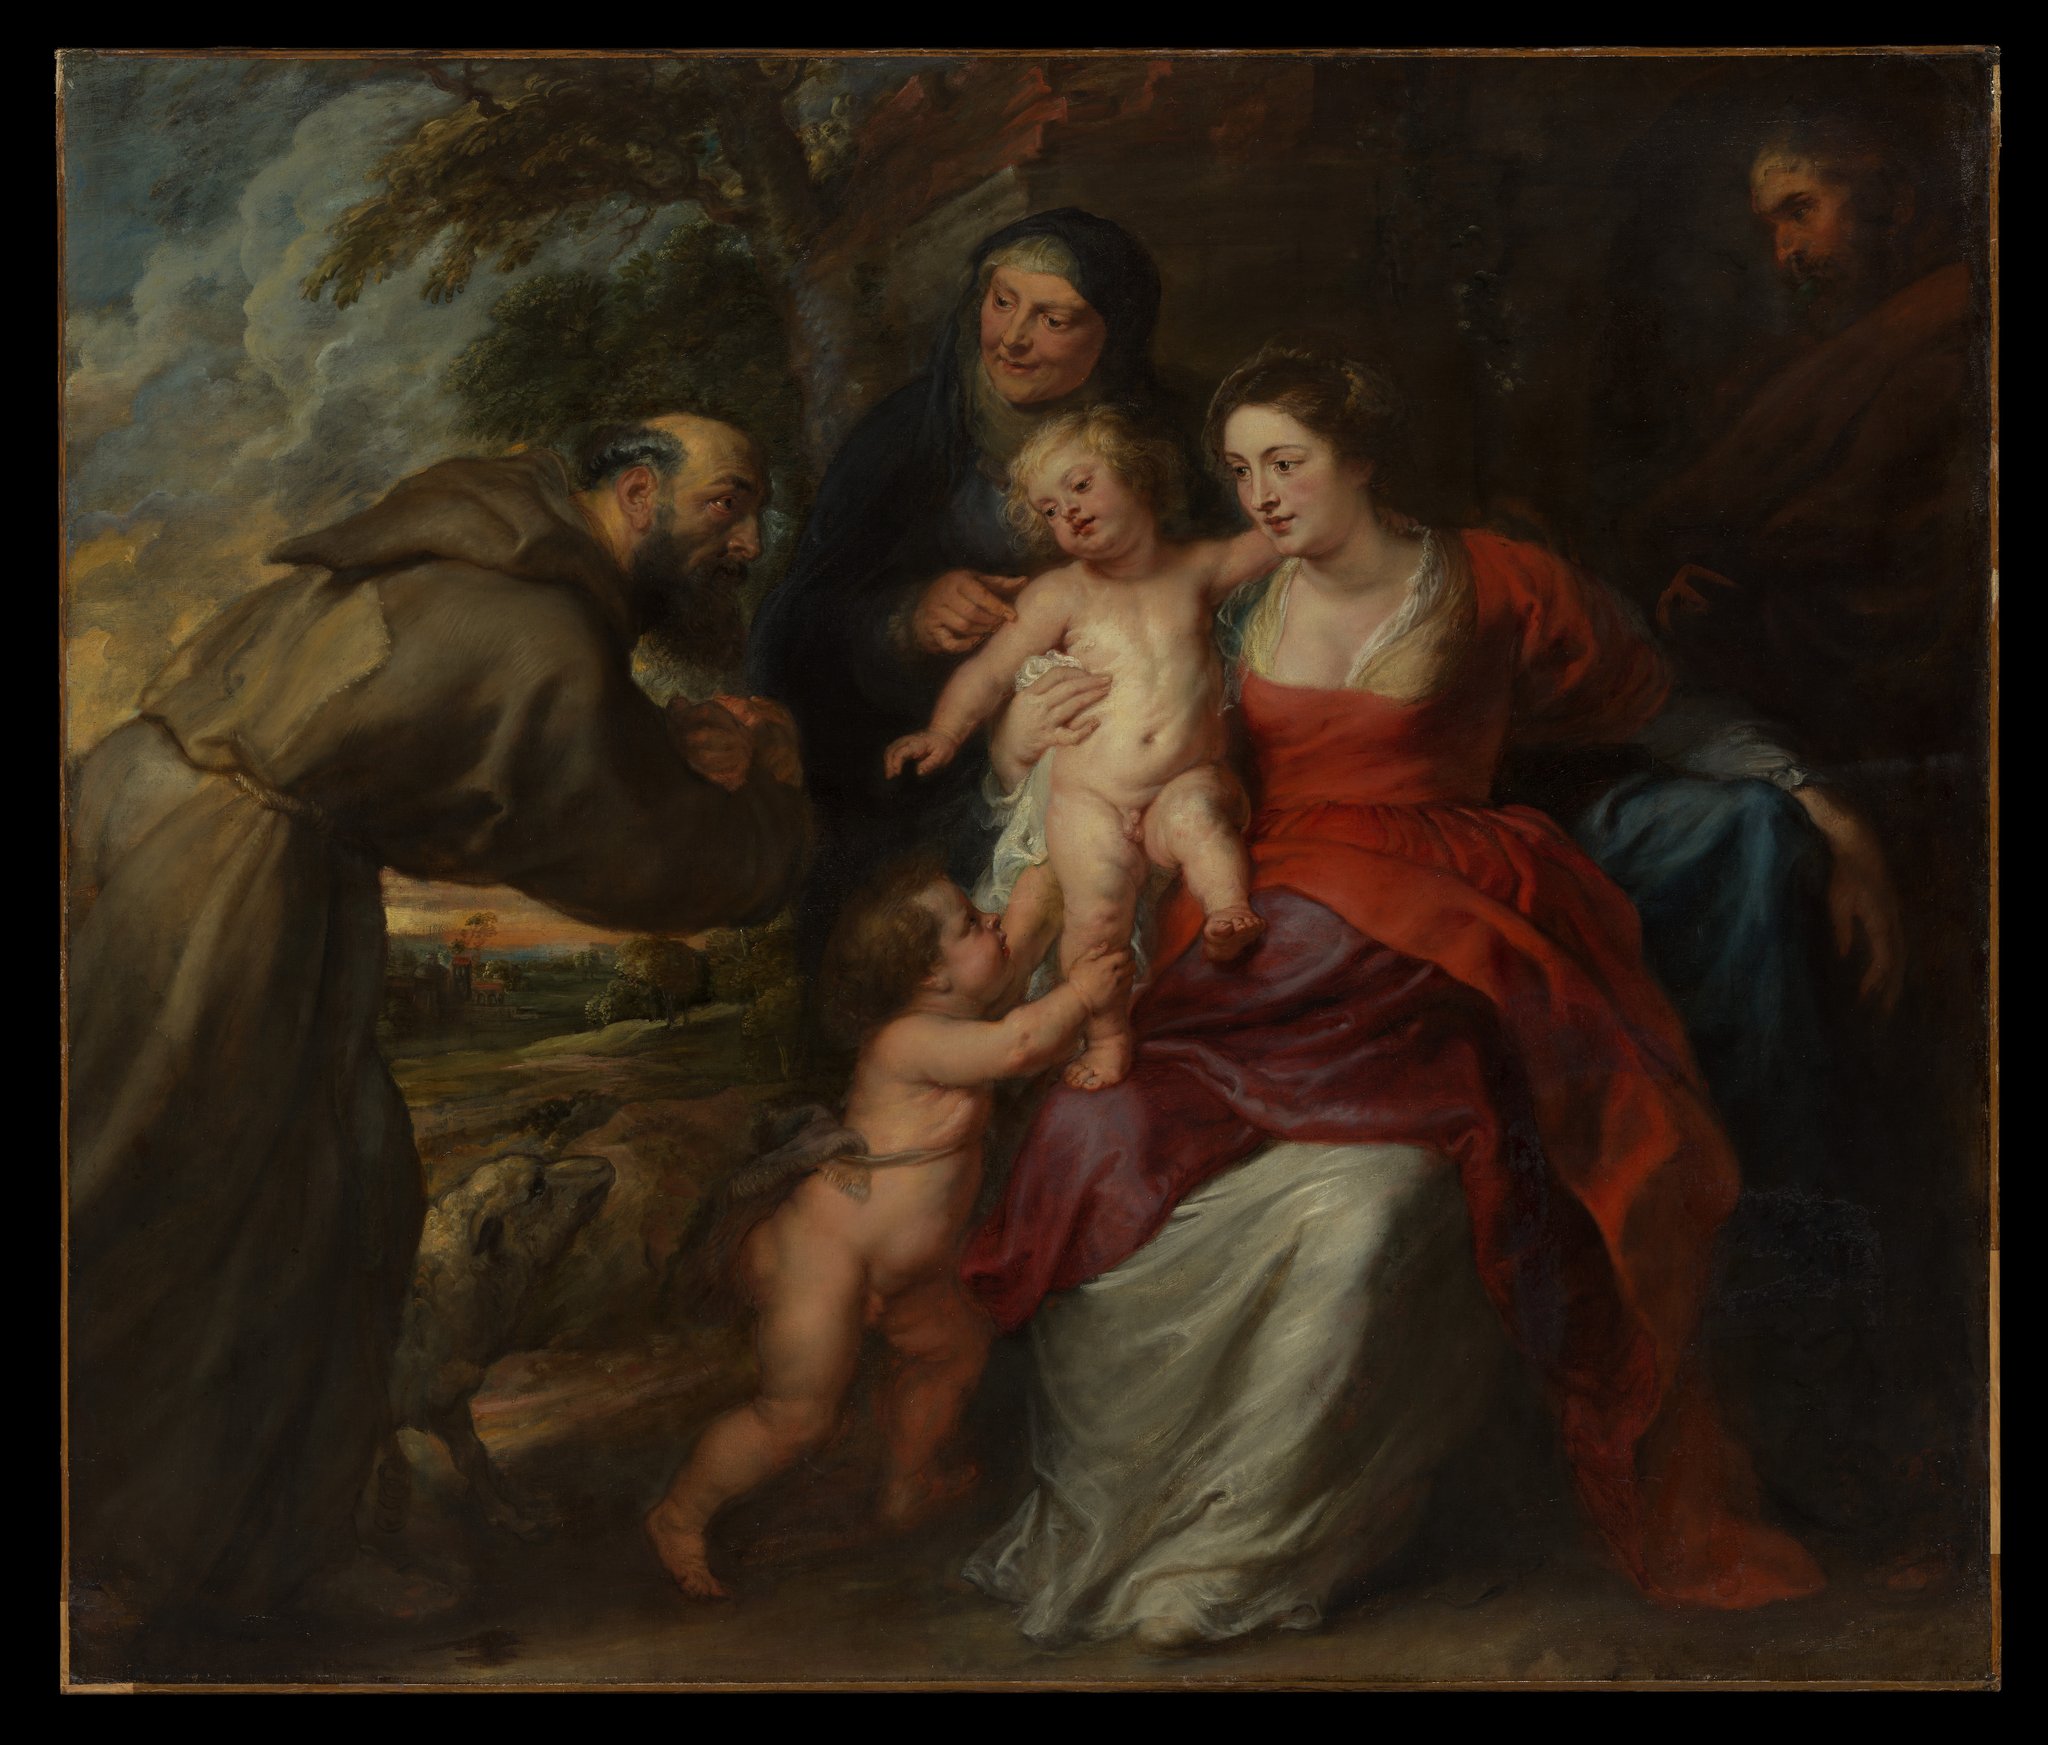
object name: painting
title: The Holy Family with Saints Francis and Anne and the Infant Saint John the Baptist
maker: peter paul rubens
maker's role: artist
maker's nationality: flemish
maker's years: 1577-1640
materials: canvas, oil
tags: sheep,holy family,saint anne,saint francis,saint john the baptist